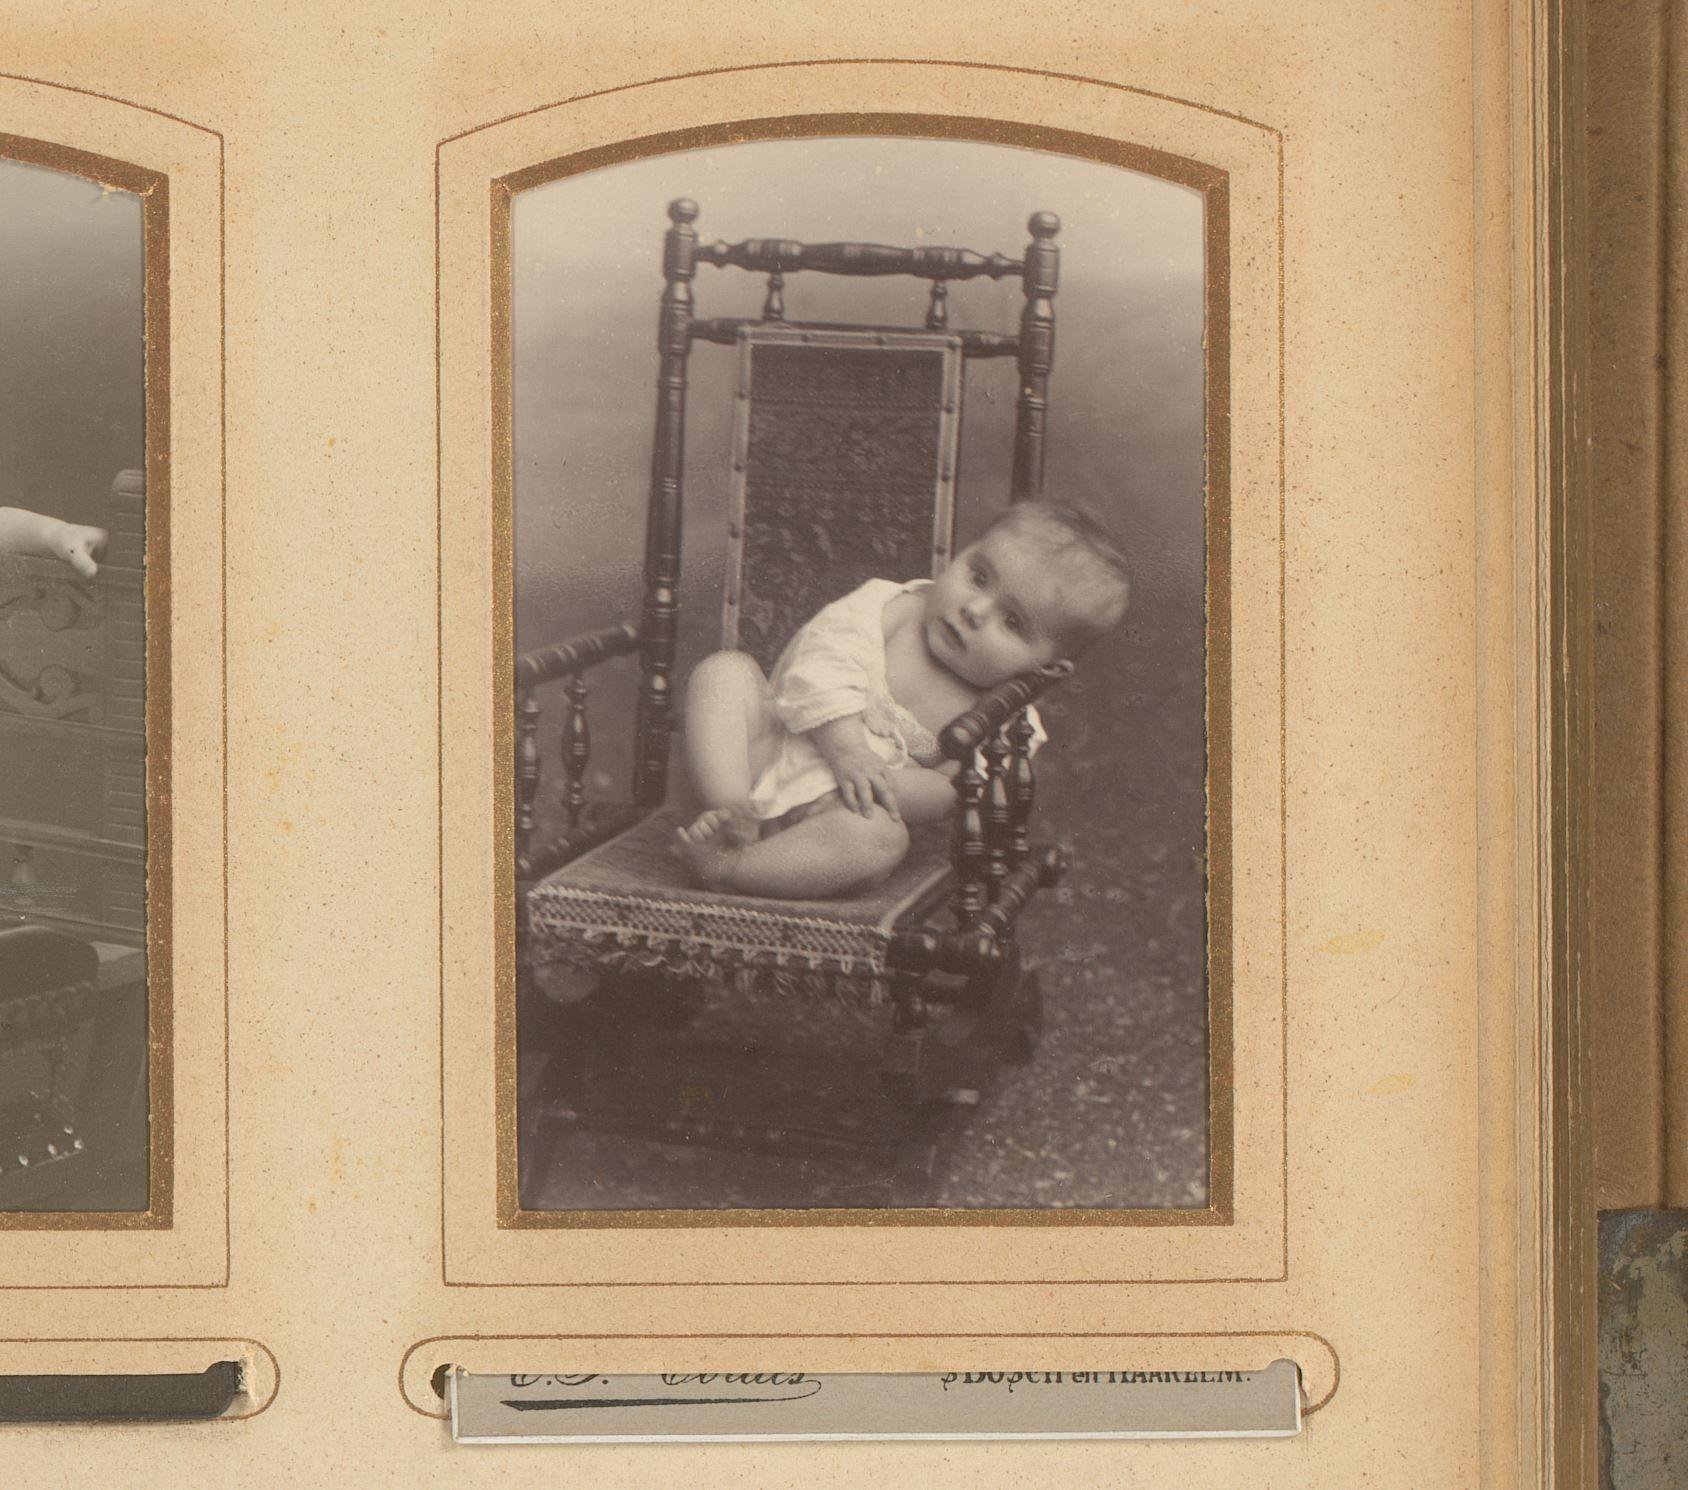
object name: photograph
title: Portret van een kind, zittend in een stoel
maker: carel frederik cordes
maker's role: fotograaf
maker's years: 1851-1927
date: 1882-1920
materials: cardboard, photographic support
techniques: collodion silver print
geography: netherlands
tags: child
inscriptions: inscription: ‘Photogr. Inrichting/ C.F. Cordes/ 's Bosch/ aan de Parade/ Haarlem, Groote Houtstraat 84’, inscription: ‘C.F. Cordes/ 's Bosch en Haarlem’